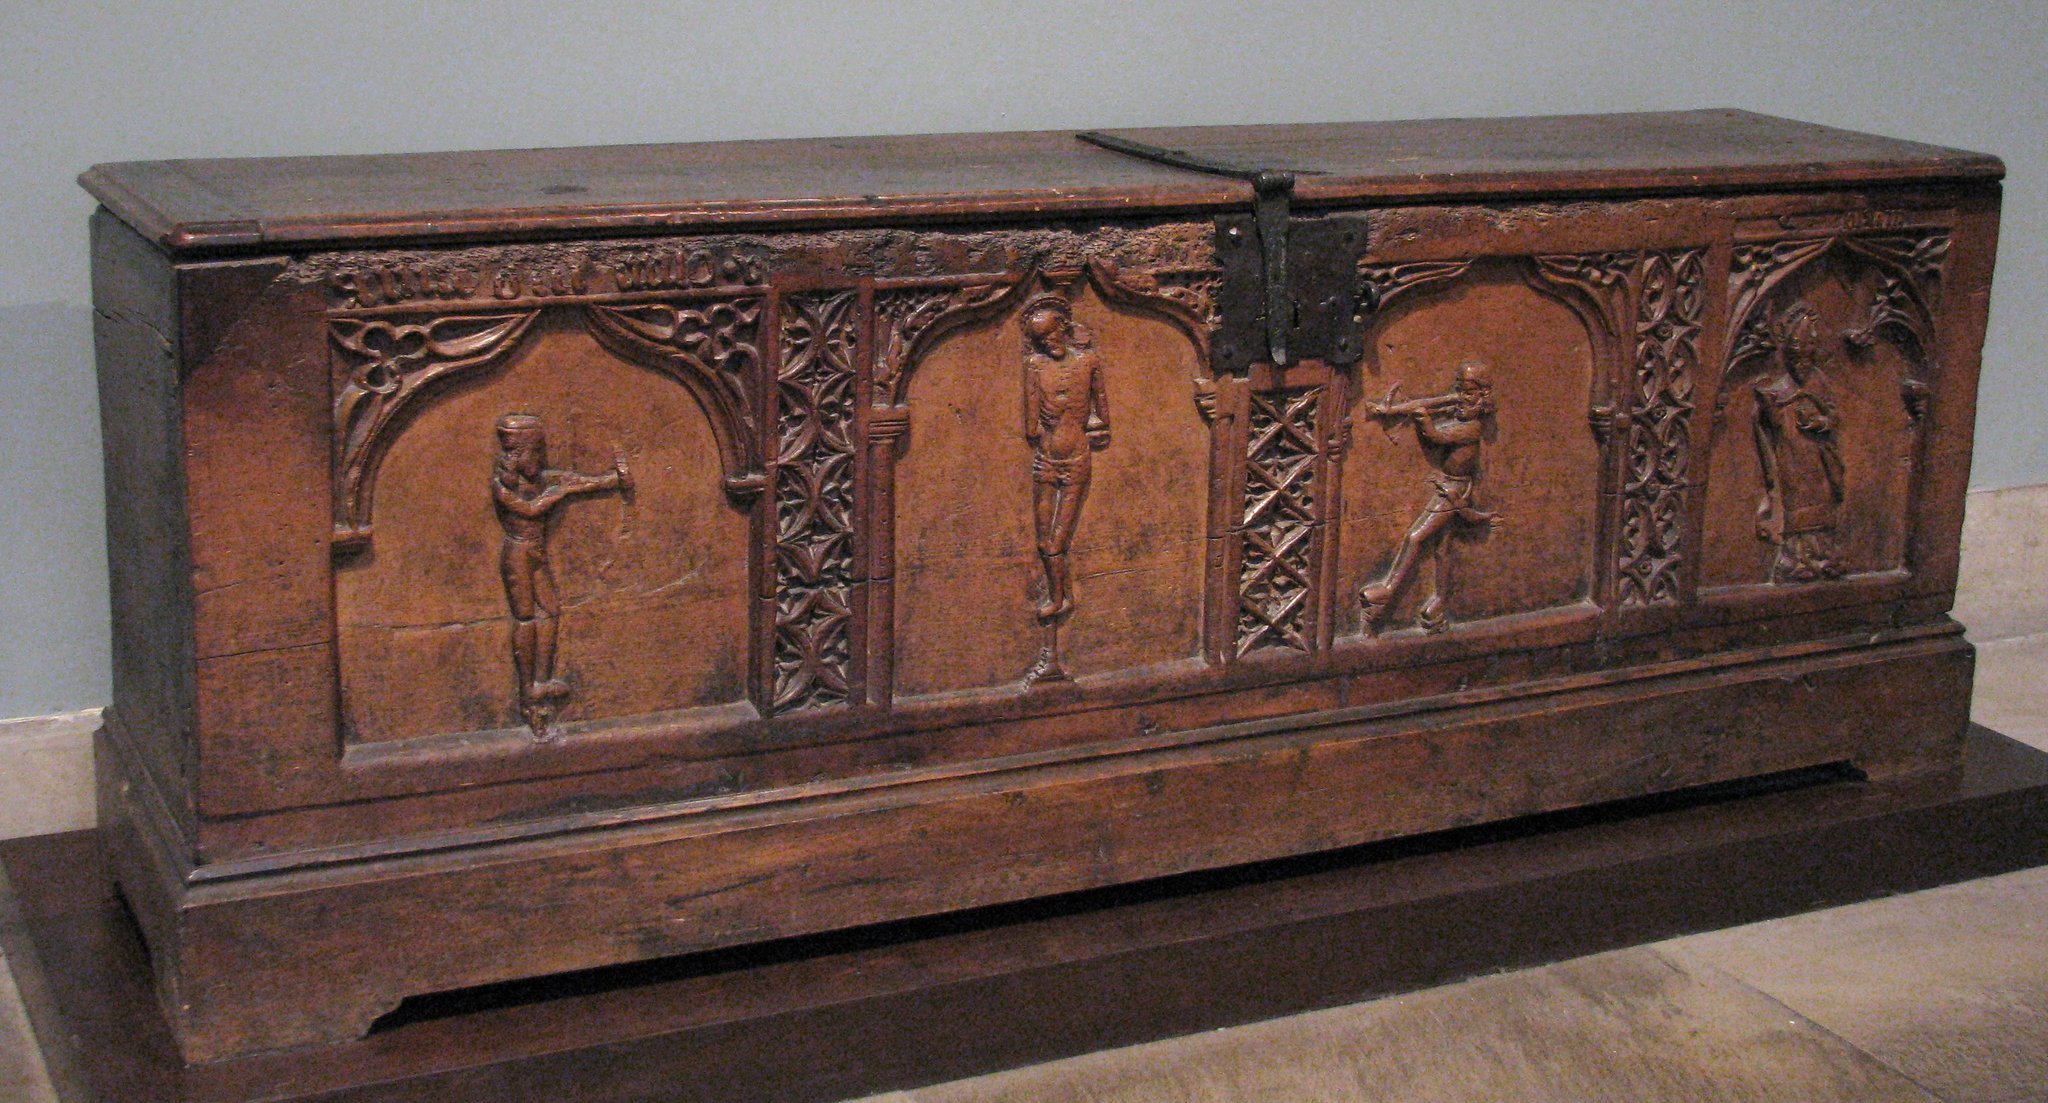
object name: chest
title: Chest with Relief Figures of Saints Sebastian and Blaise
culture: italian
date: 1501-1533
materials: iron, wood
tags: bow and arrow,men,saints